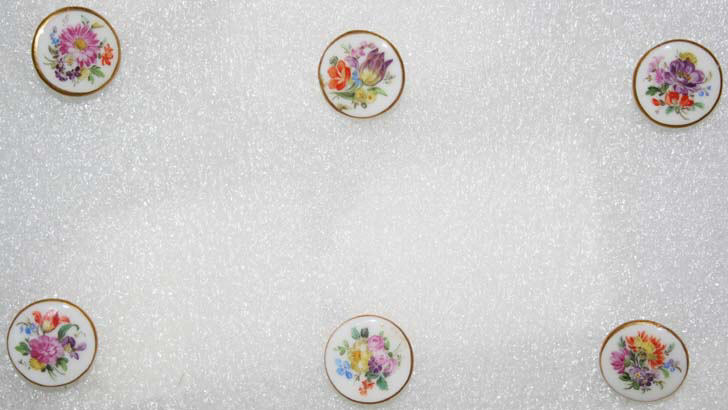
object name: button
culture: european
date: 1850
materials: porcelain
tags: flowers